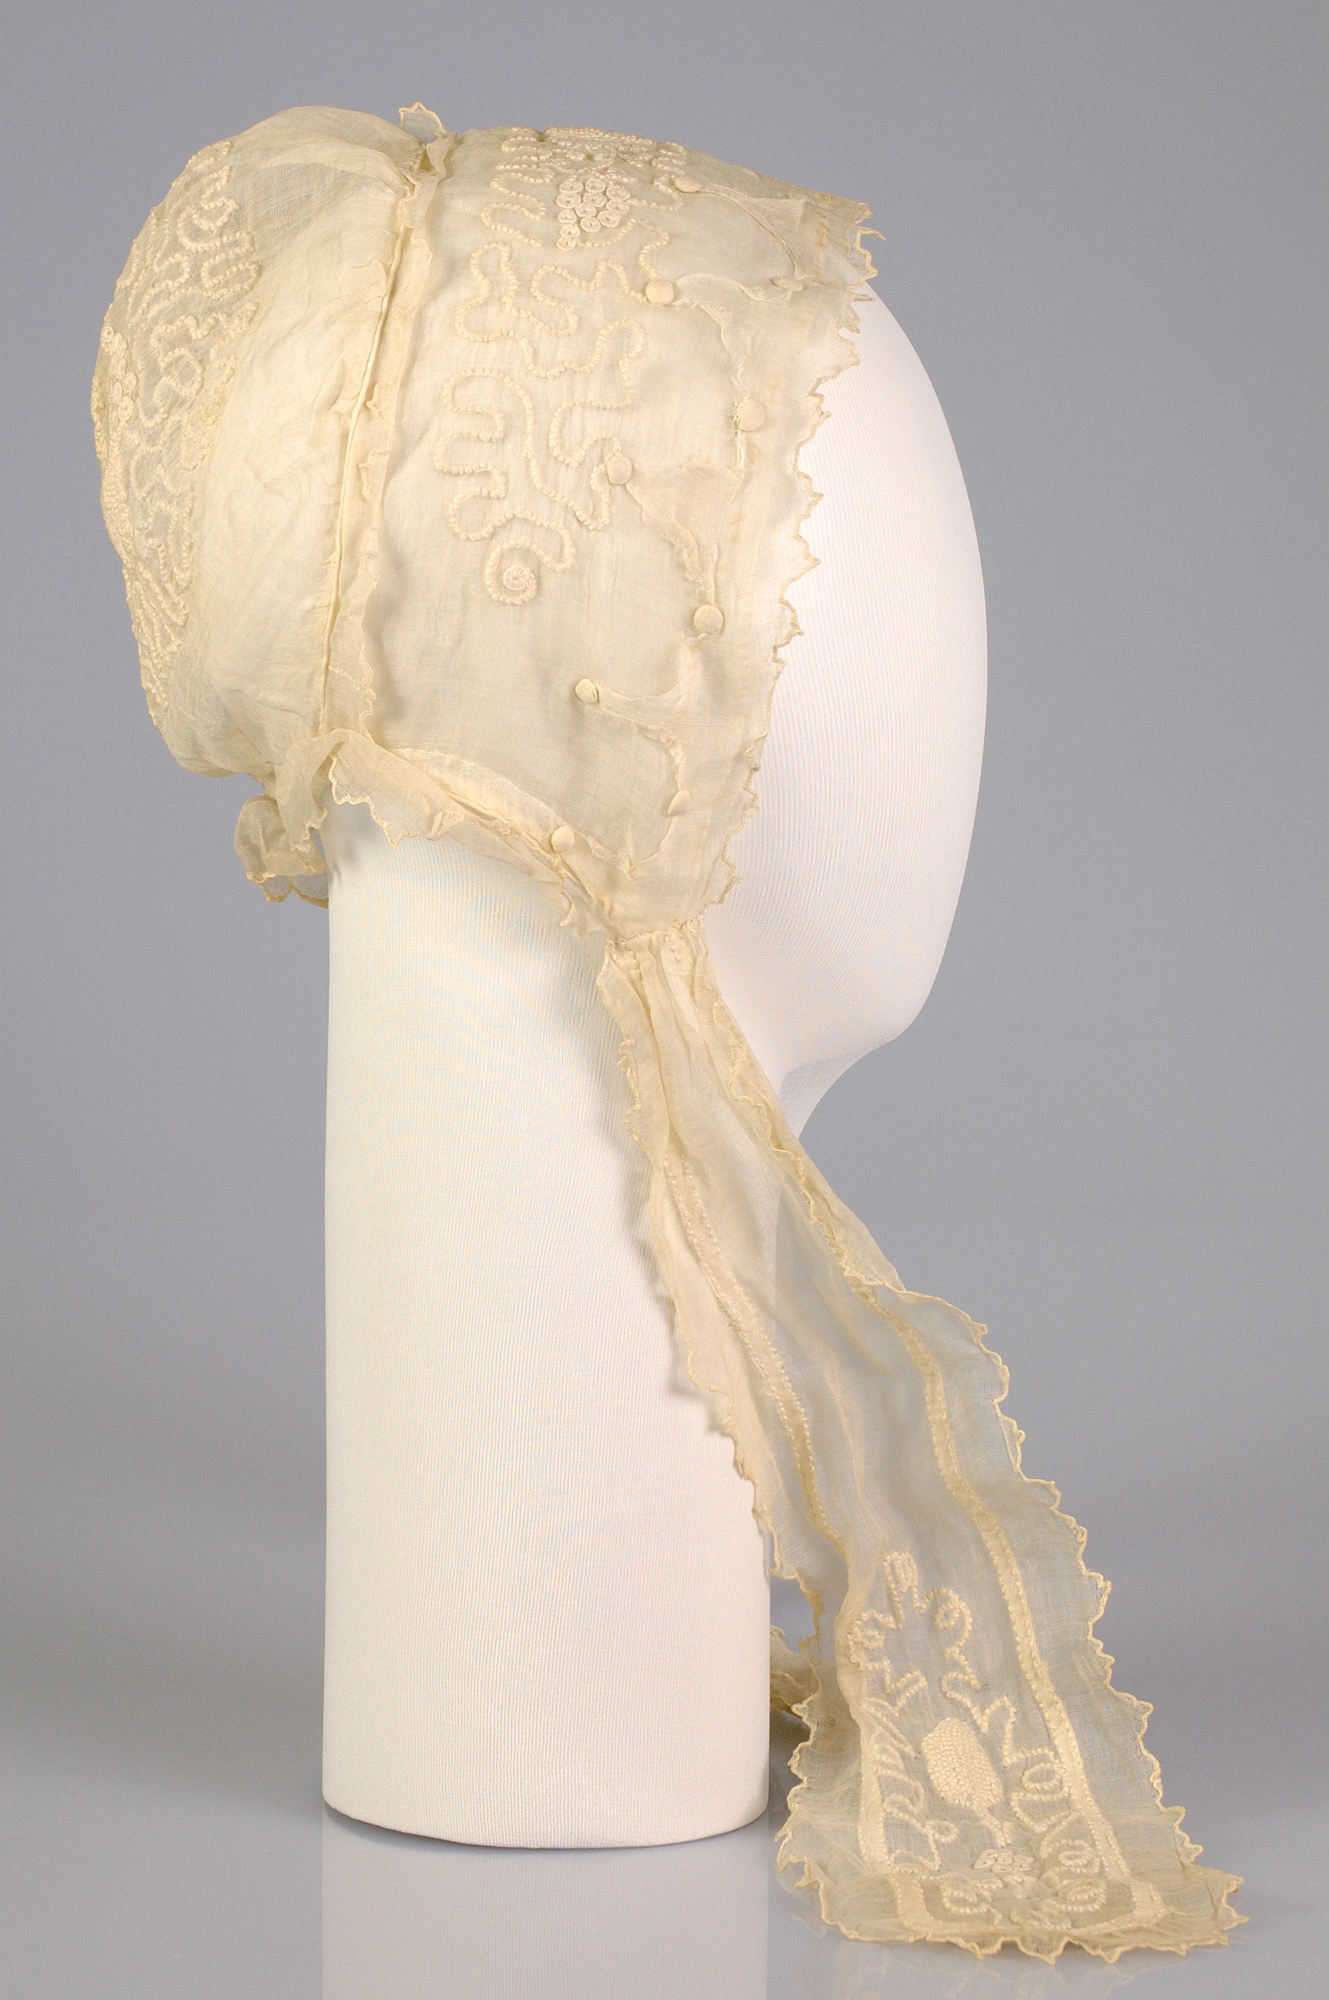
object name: nightcap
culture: american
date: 1850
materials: cotton